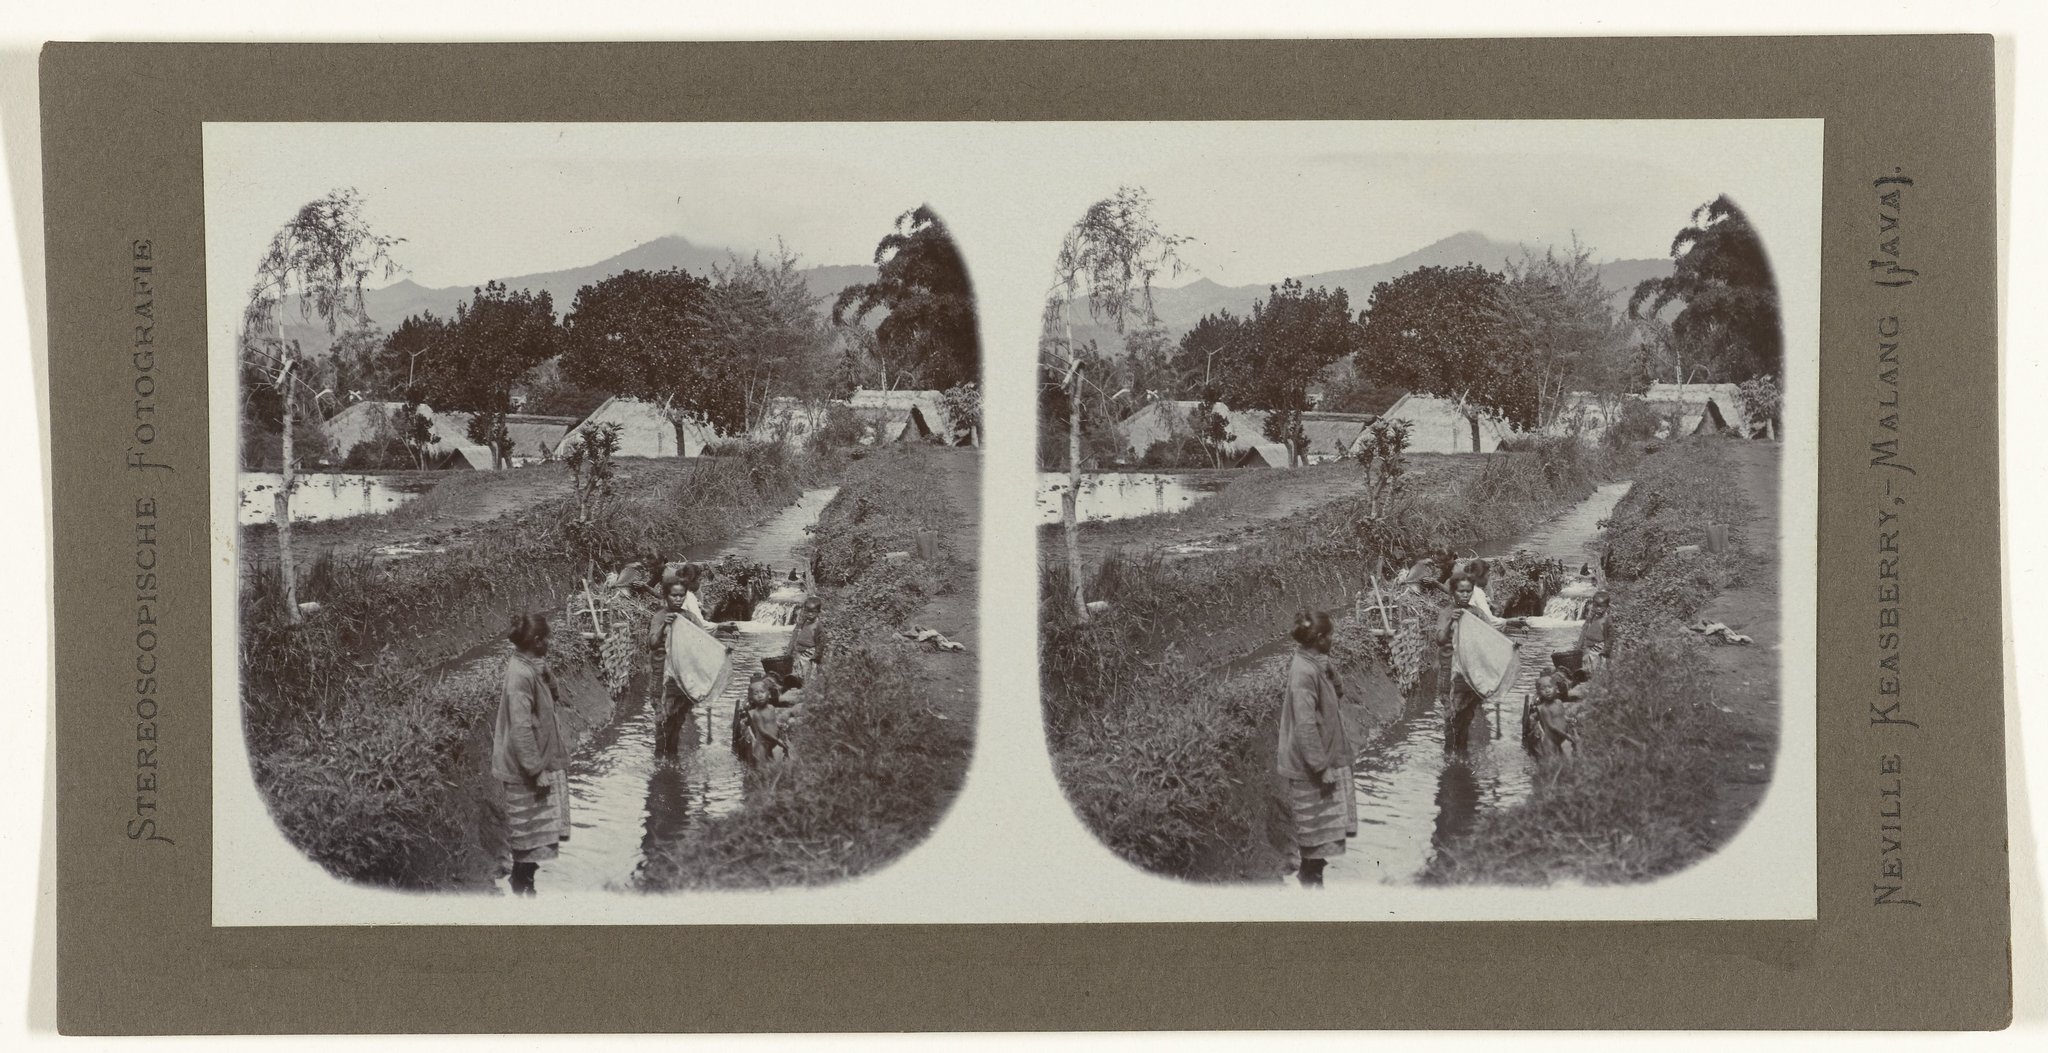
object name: photograph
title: S 8 No 86. Een dessa in 't Gebergte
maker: neville keasberry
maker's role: fotograaf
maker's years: 1866-1944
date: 1900-1935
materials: cardboard, paper, photographic support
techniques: albumen print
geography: malang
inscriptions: signature: ‘Neville Keasberry, Malang (Java)’, inscription: ‘Stereoscopische Fotografie’